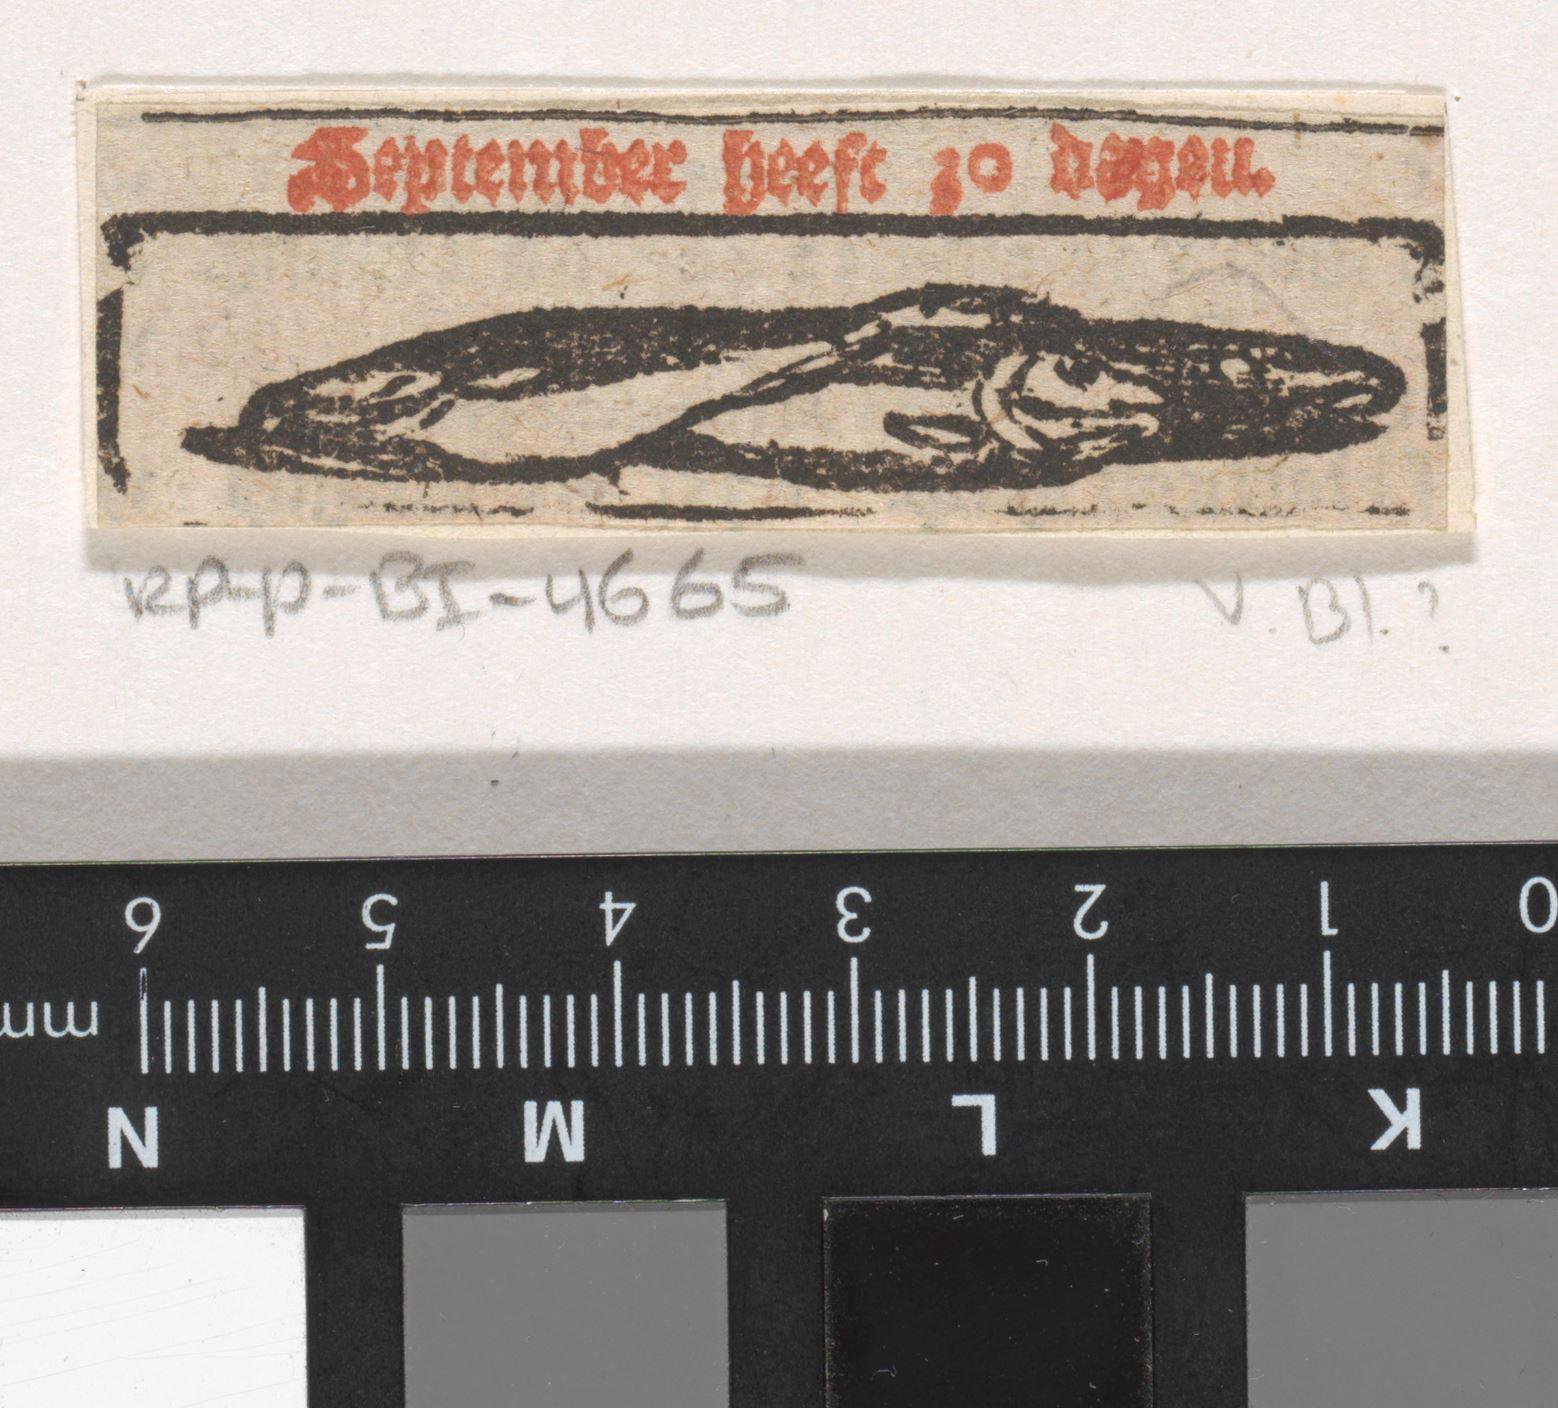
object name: print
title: September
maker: dirck de bray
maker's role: draughtsman, painter, print maker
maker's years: 1625-1694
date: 1672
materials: paper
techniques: letterpress printing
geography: netherlands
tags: september ~ other concepts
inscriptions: collector's mark: Lugt 2228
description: Een aantal vissen. In de bovenmarge een regel Nederlandse tekst.